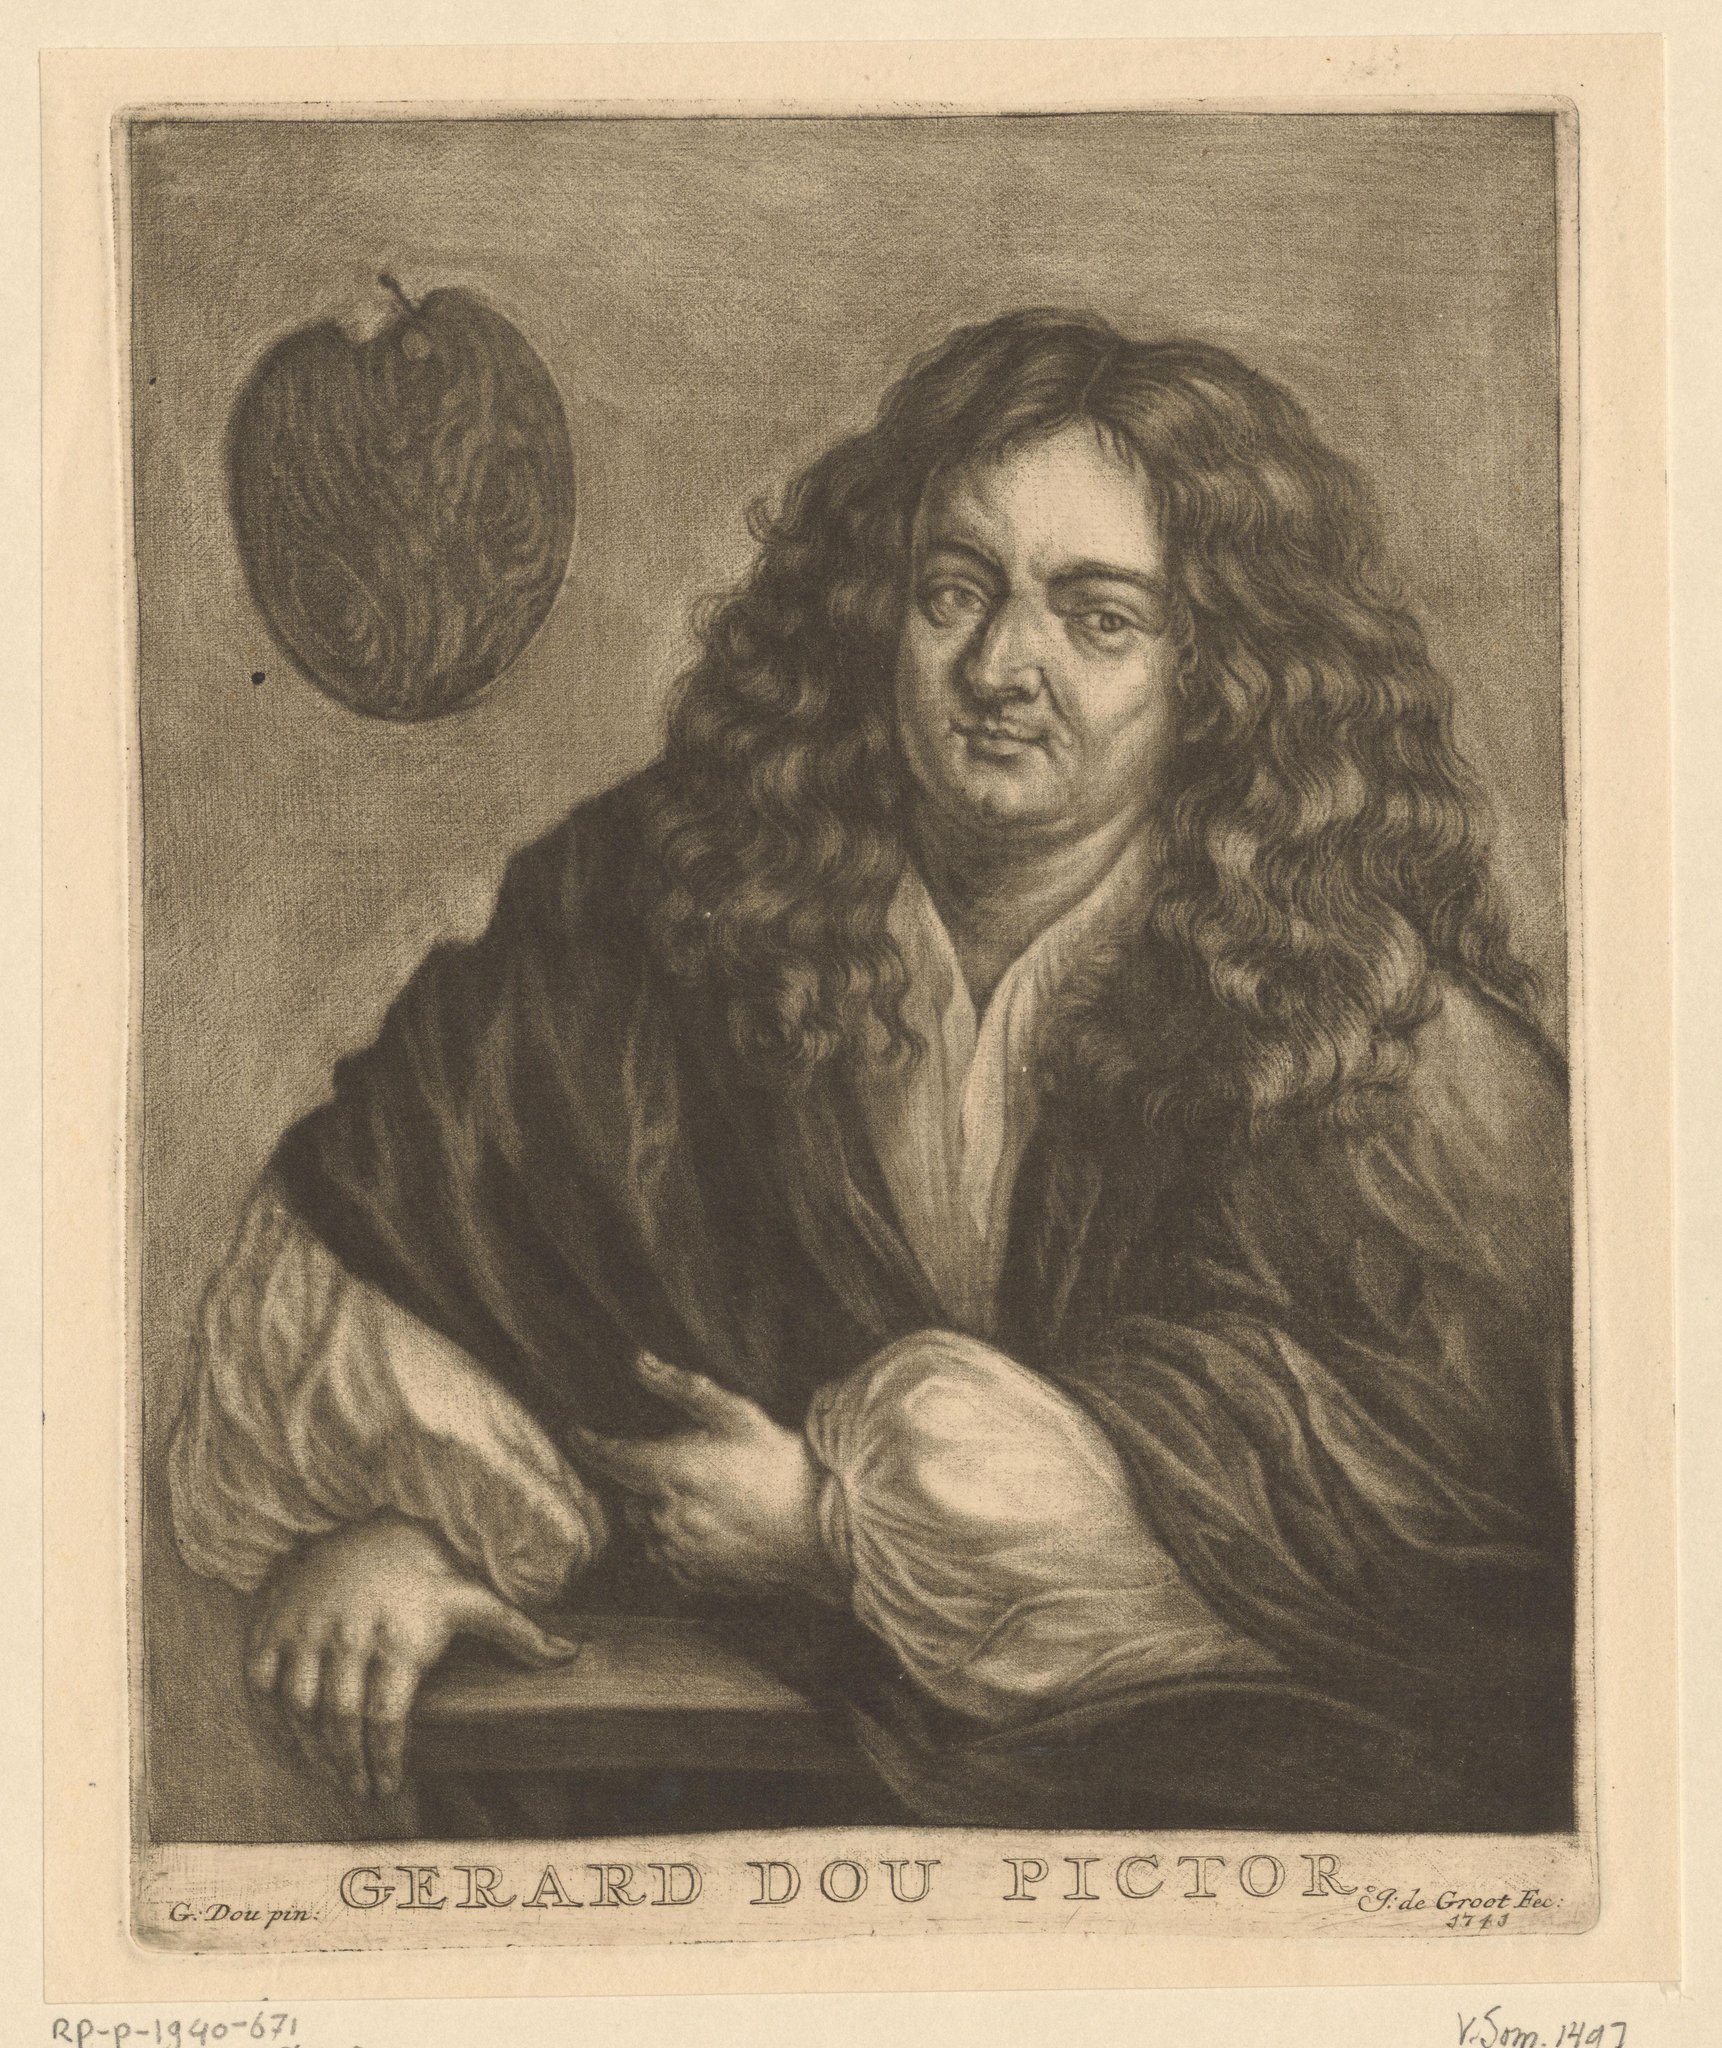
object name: print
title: Portret van Gerard Dou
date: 1743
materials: paper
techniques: engraving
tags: leiden, painter, draughtsman, gerard dou, historical persons, portrait, self-portrait of artist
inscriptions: collector's mark: Lugt 2760, collector's mark: Lugt 2228